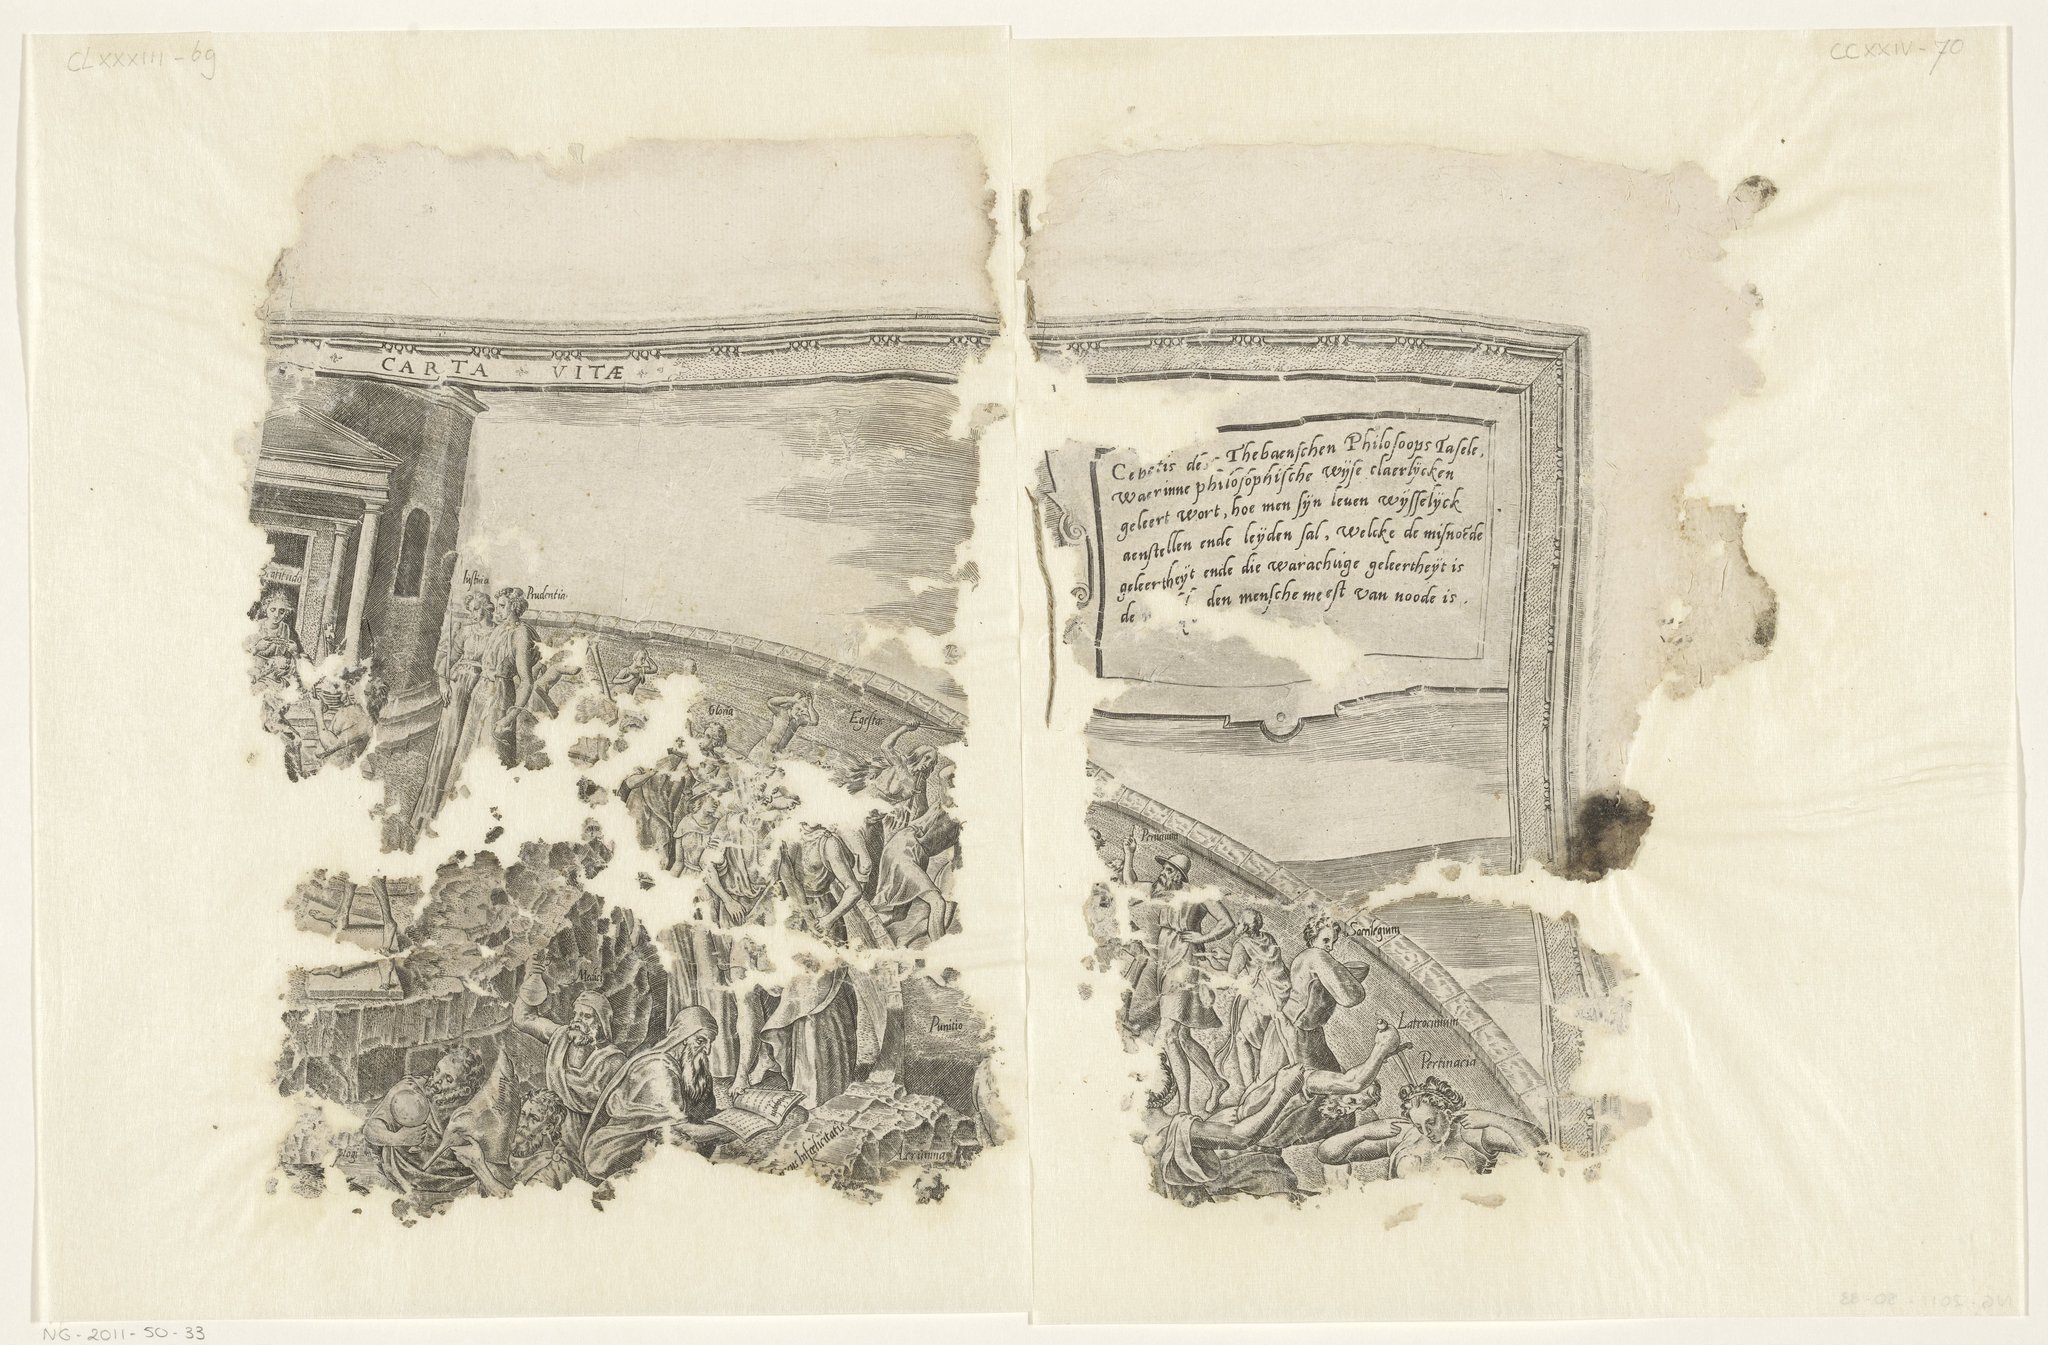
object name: print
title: Rechterbovenhoek van een prent van het tafereel van Cebes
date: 1561-1596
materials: paper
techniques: engraving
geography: southern netherlands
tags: 'tabula cebetis'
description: Allegorie over de heilsweg van de mens. Het leven als een stad met drie ommuurde terreinen, met in het midden een tempel. Bij de buitenste poort staan de zielen van kinderen te wachten, klaar om het volwassen leven te betreden. Voor het binnengaan krijgen zij iets te drinken van Verleiding (Seductio), die hen onwetend maakt. Het eerste ommuurde terrein toont allerlei ver- en afleidingen, zoals Vooroordeel (Opinio), Begeerte (Cupiduas), Twijfel (Error) en Onwetendheid (Ignorantia). Zij beletten de jeugdige mens verder door te dringen tot de volgende cirkel. Alleen door de personificaties te volgen van Berouw (Poenitentia), Hoop (Spes) en Goed Verlangen (Bonnem Desiderium) kan de mens toegang krijgen tot de tweede cirkel. Daar krijgt hij onderricht in alle vormen van wereldse kennis. Links staan de zeven artes liberales en rechts debatteren verschillende geleerden. De mens wordt in deze cirkel op de proef gesteld en geconfronteerd met valse kennis (Falsa Disciplina). Met behulp van Zelfbeheersing (Continentia) en Geduldigheid (Tolerantia) kan de berg verder worden beklommen. Het derde ommuurde terrein, ten slotte, wordt bewaakt door Waarheid (Veritas). Zij verleent de mens toegang tot het ware geluk. Hij wordt er verwelkomd door de kardinale deugden en mag verblijven in het huis van de gelukzaligen, waar het ware geluk op hem wacht. Gereconstrueerd uit twee fragmenten.